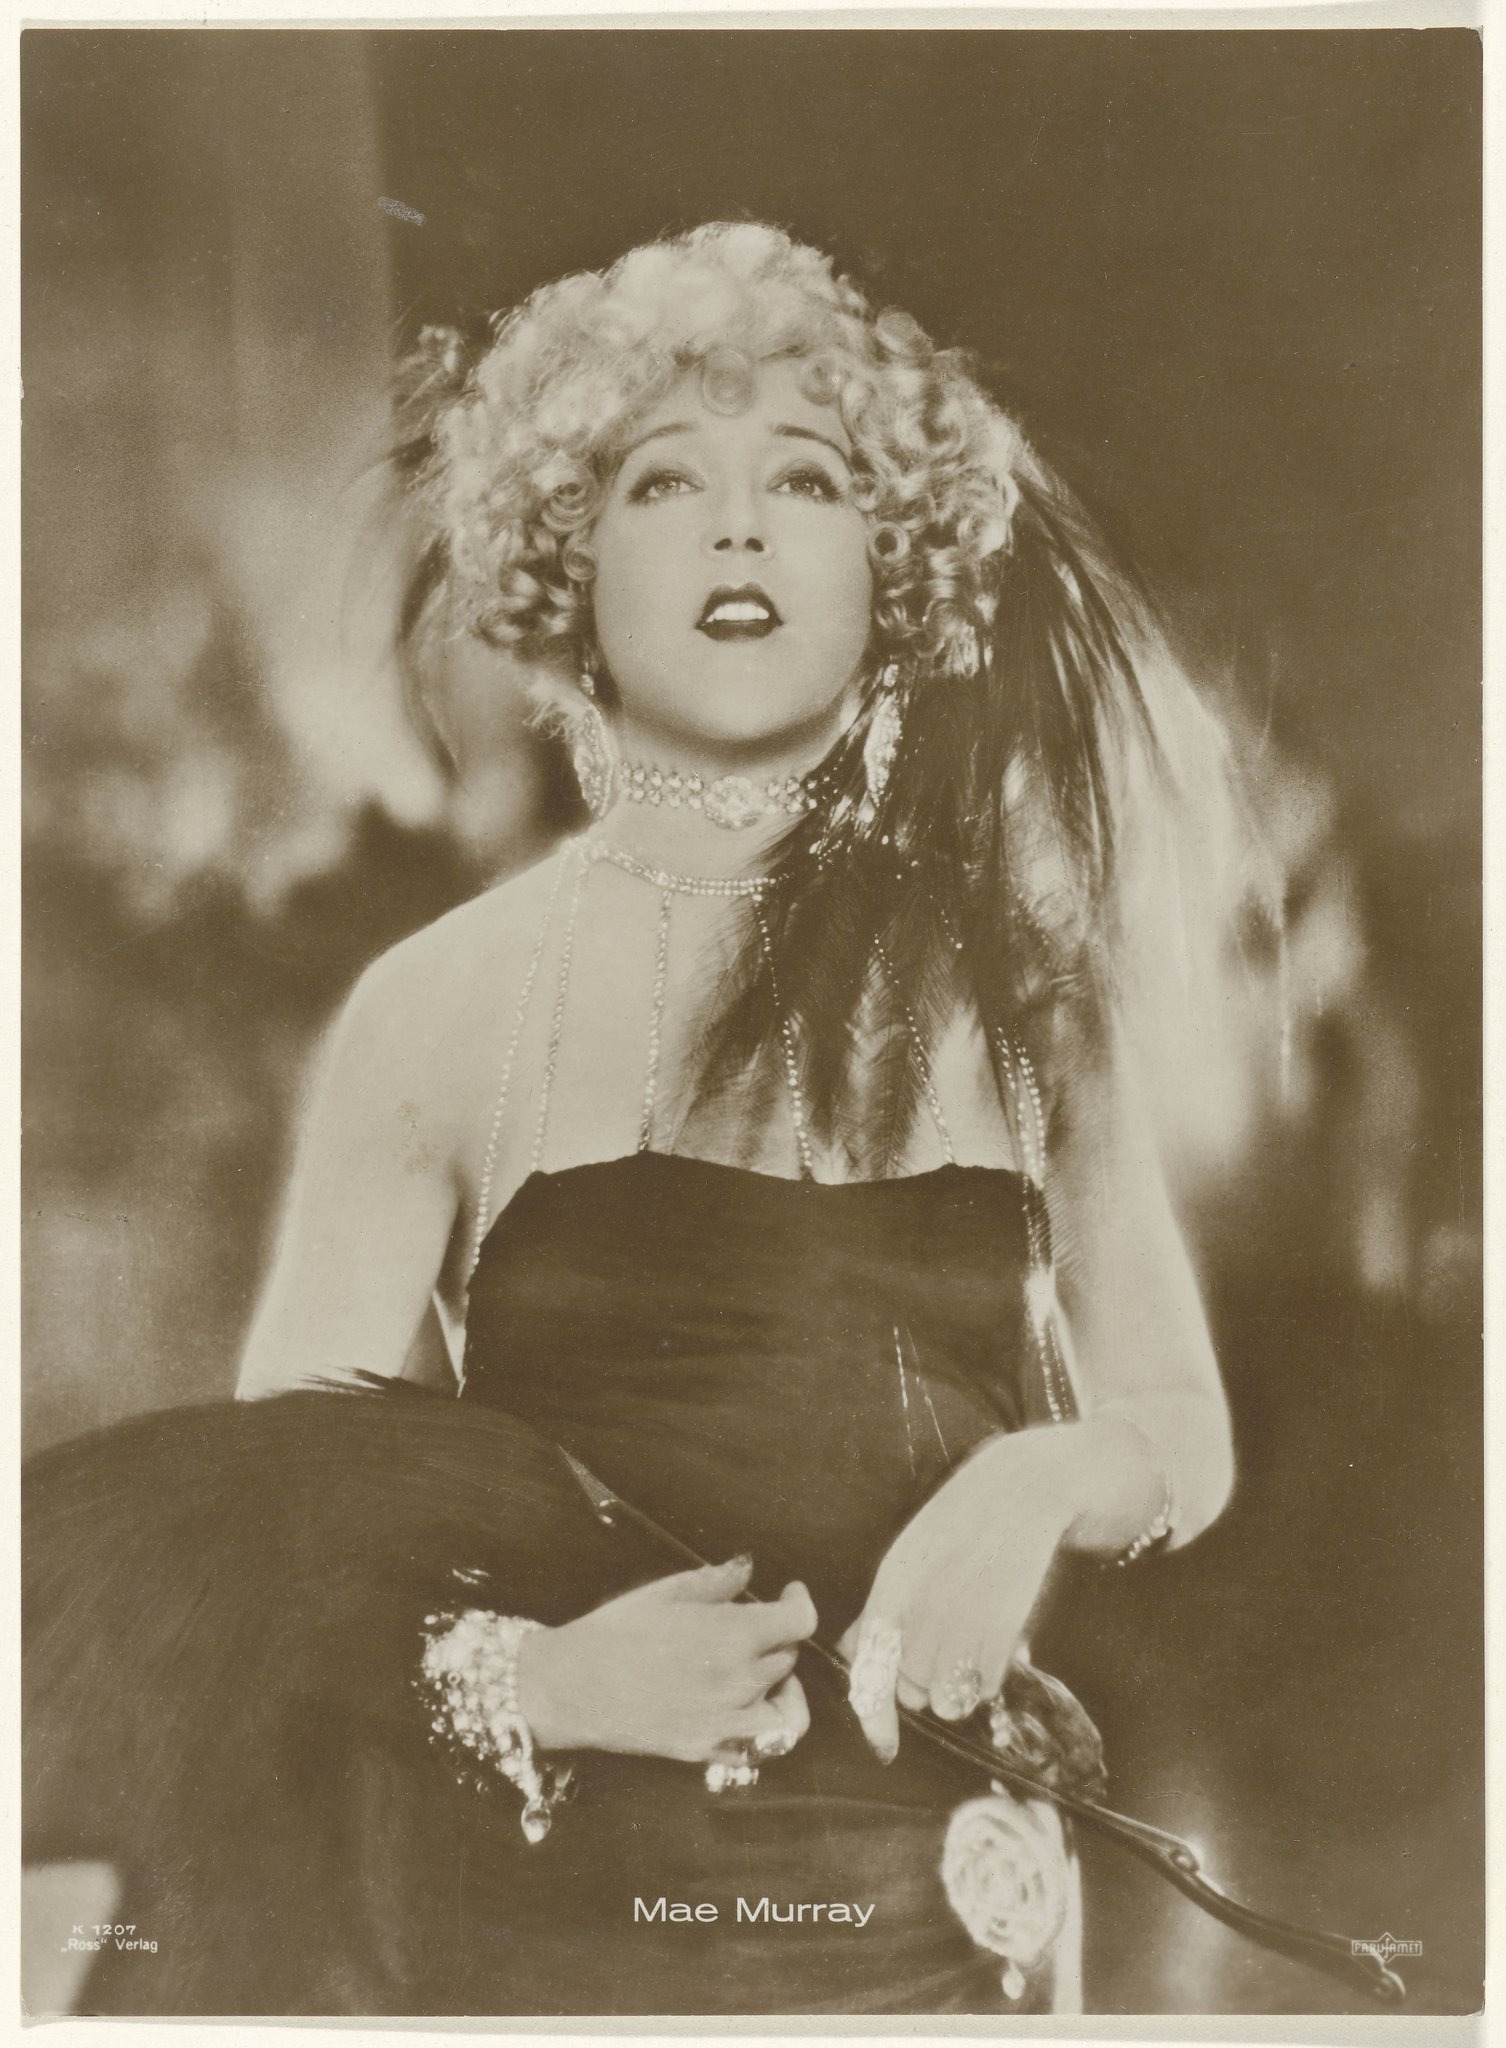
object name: photograph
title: Mae Murray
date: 1910-1940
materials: photographic support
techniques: gelatin silver print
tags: portsmouth